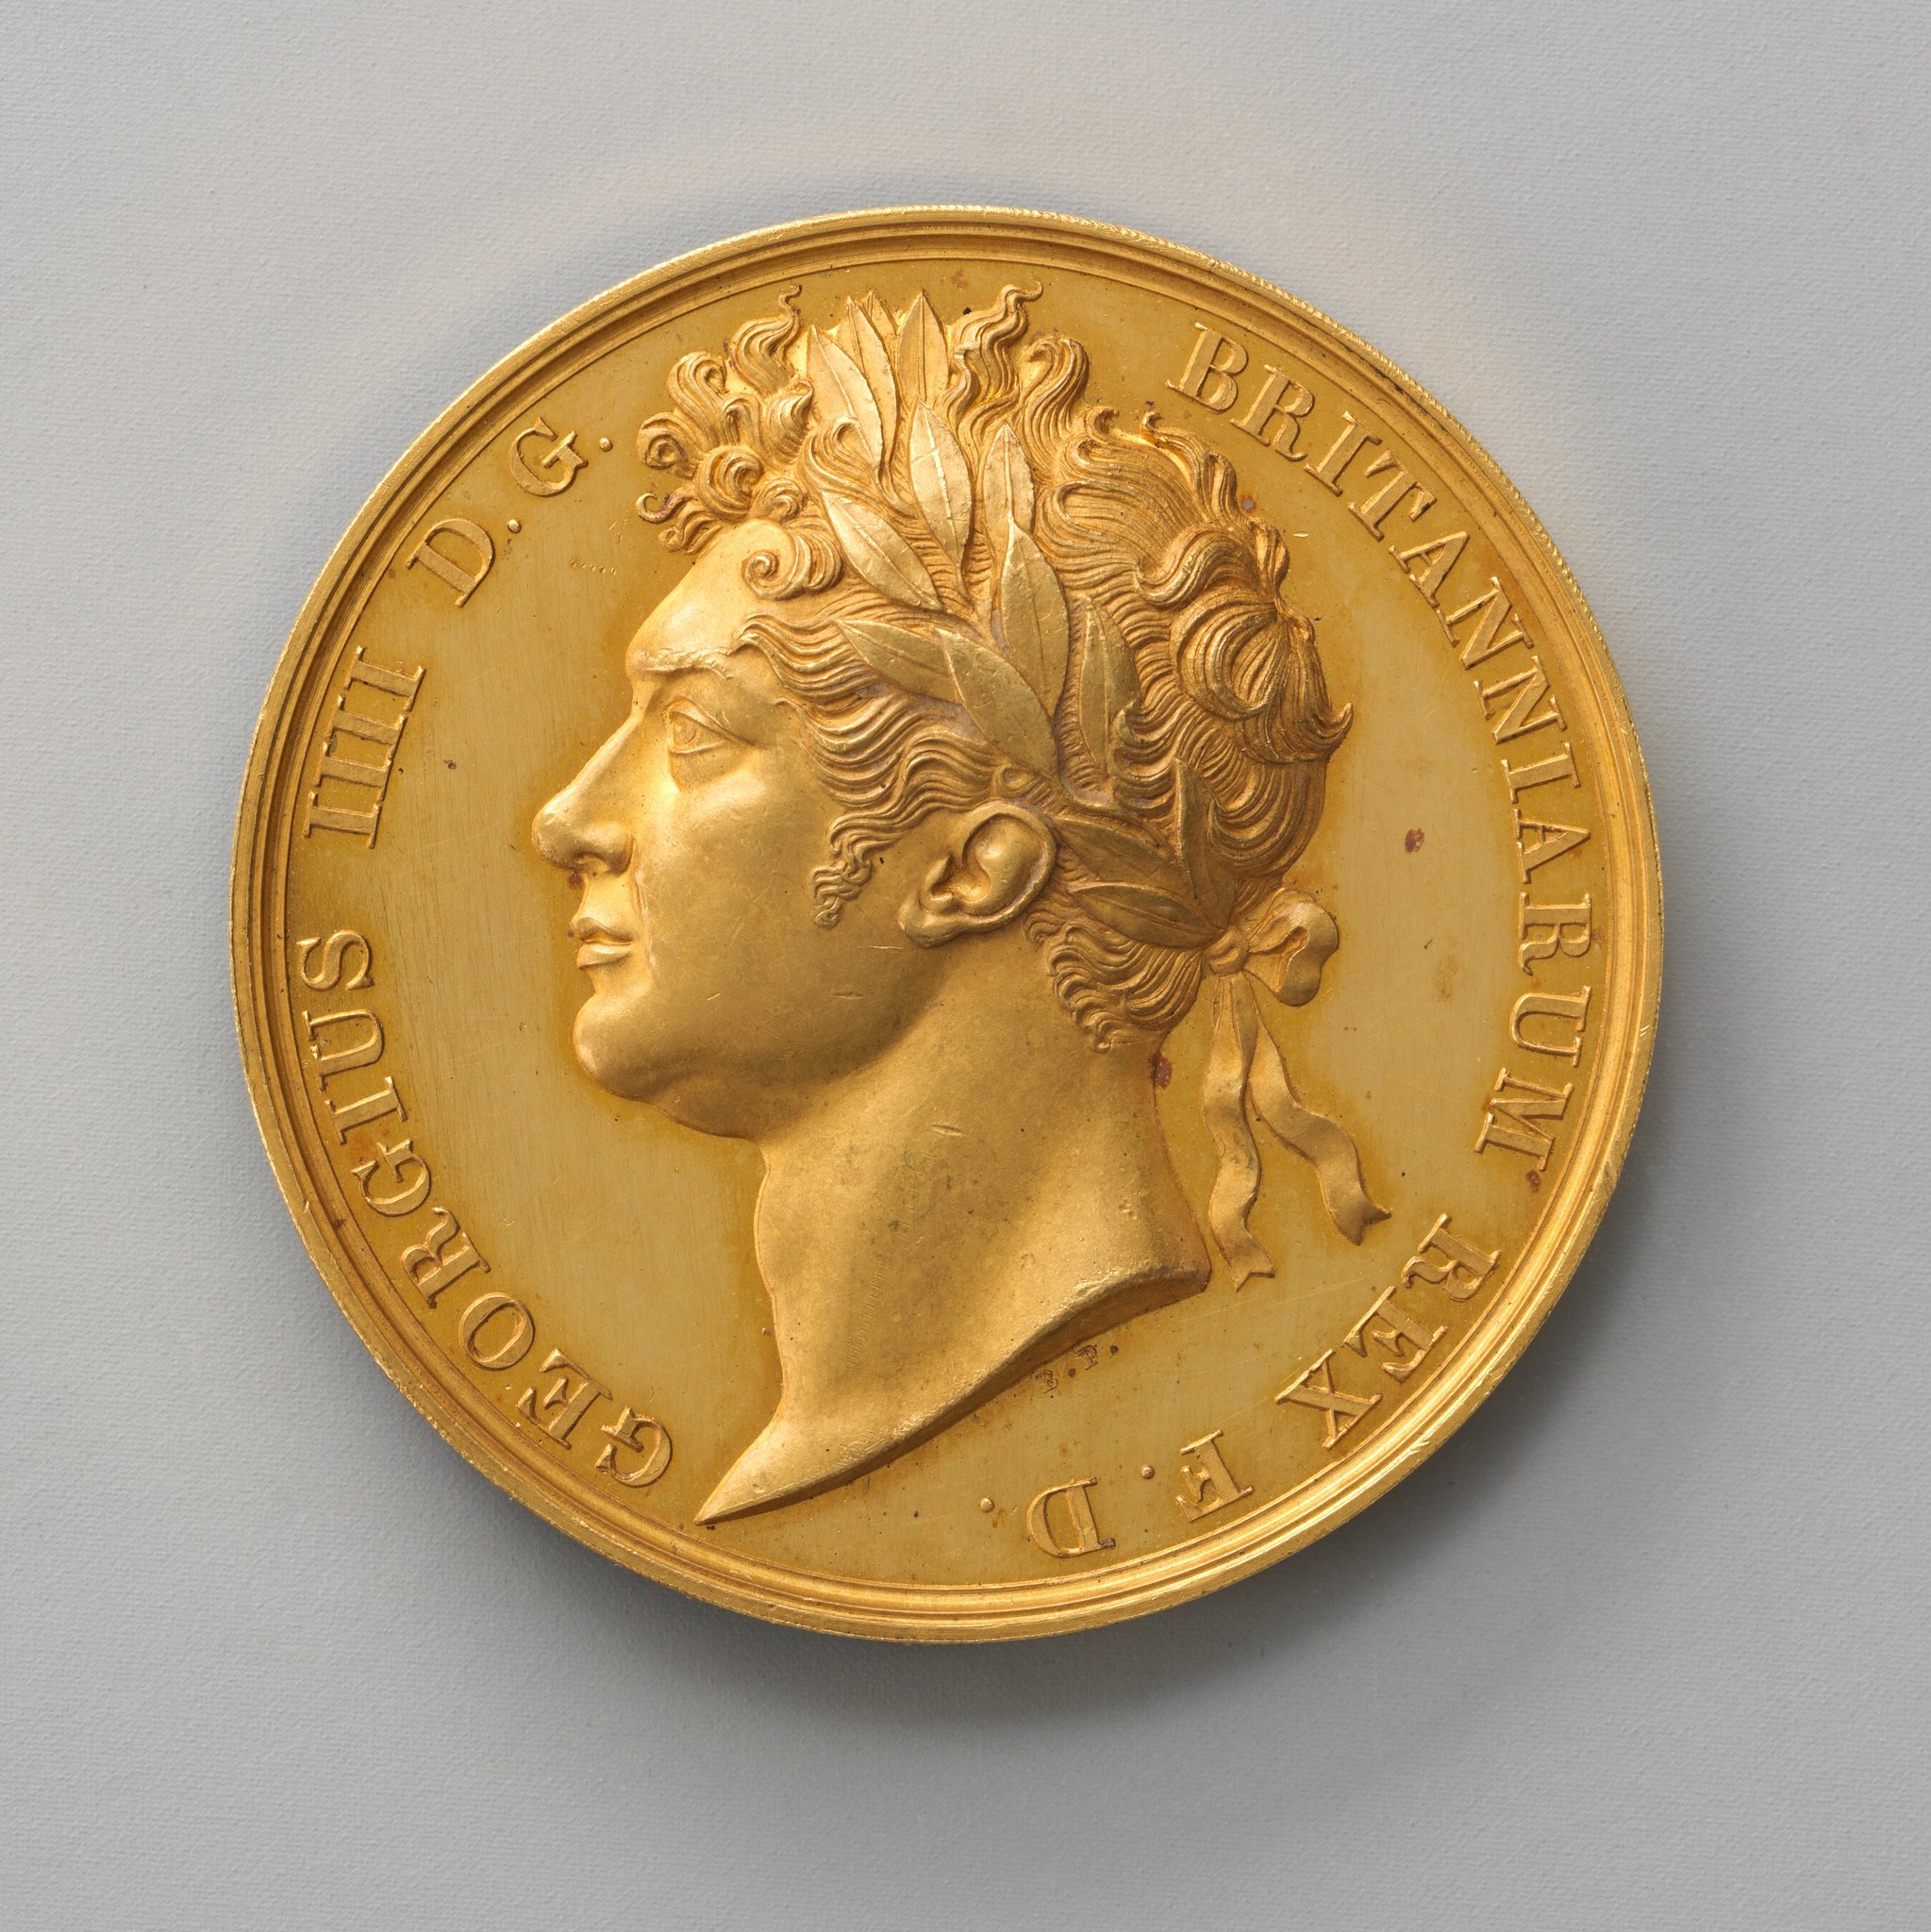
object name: medal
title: Unfinished Pattern for the Official Coronation Medal of George IV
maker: benedetto pistrucci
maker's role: artist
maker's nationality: italian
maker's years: 1783-1855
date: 1821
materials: gold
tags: kings,men,profiles